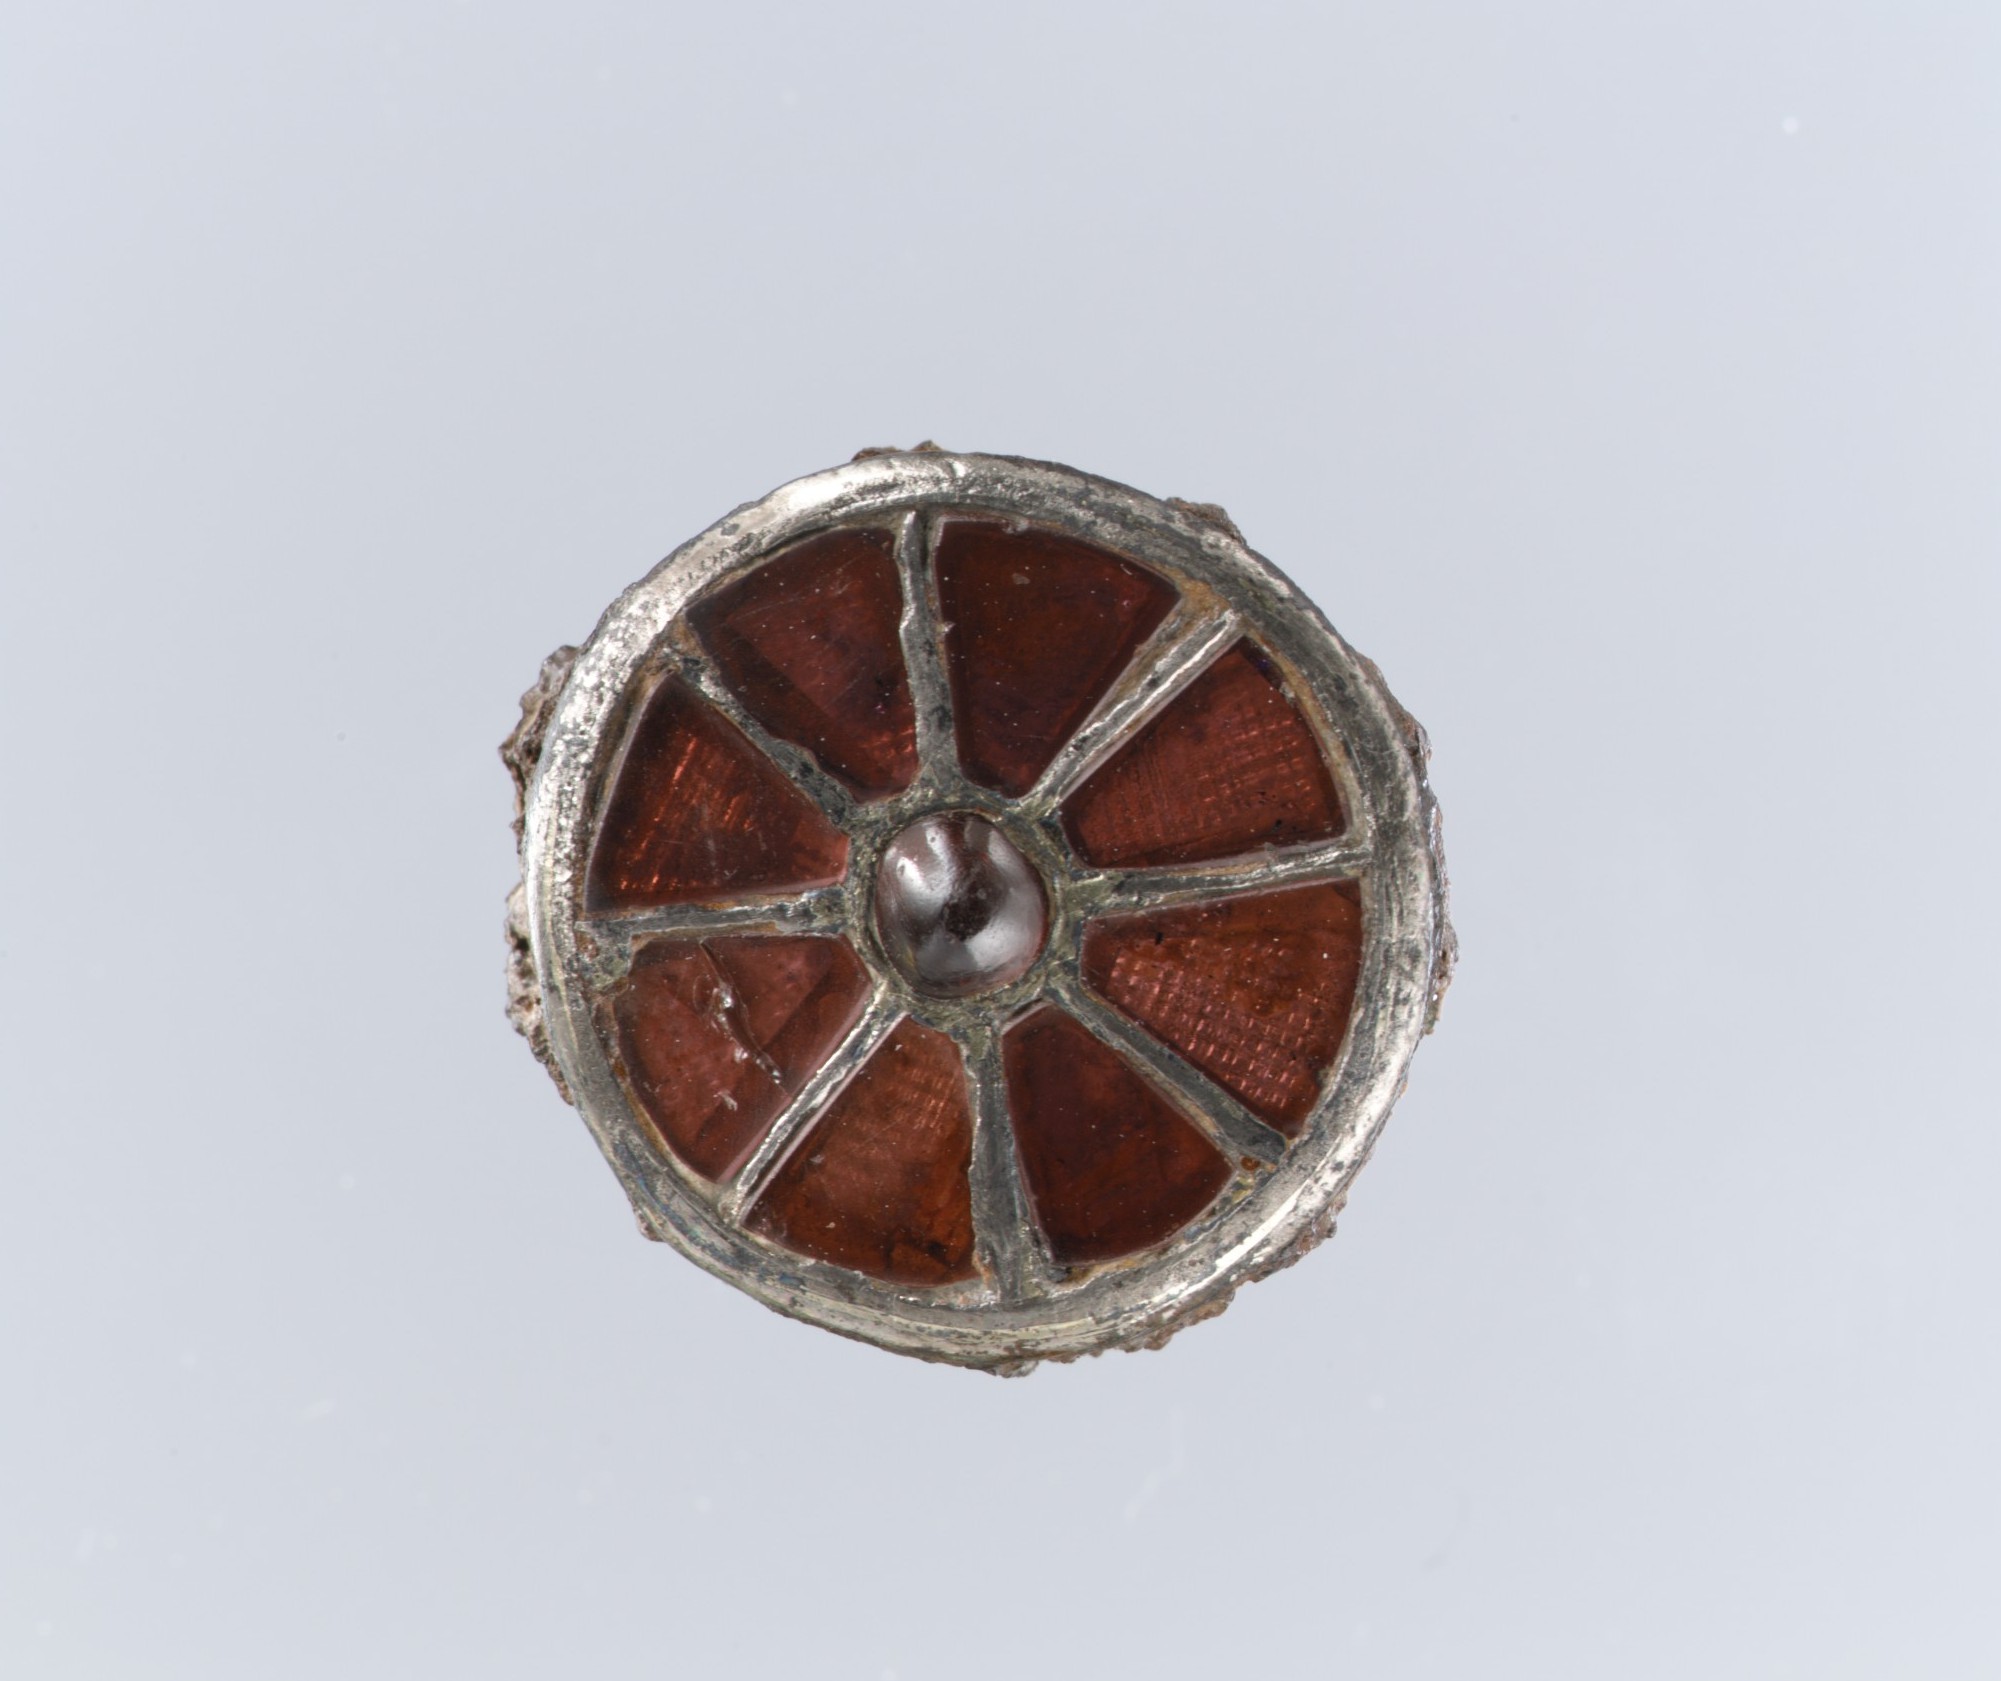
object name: brooch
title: Disk Brooch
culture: frankish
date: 501-600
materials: foil, garnet, silver gilt